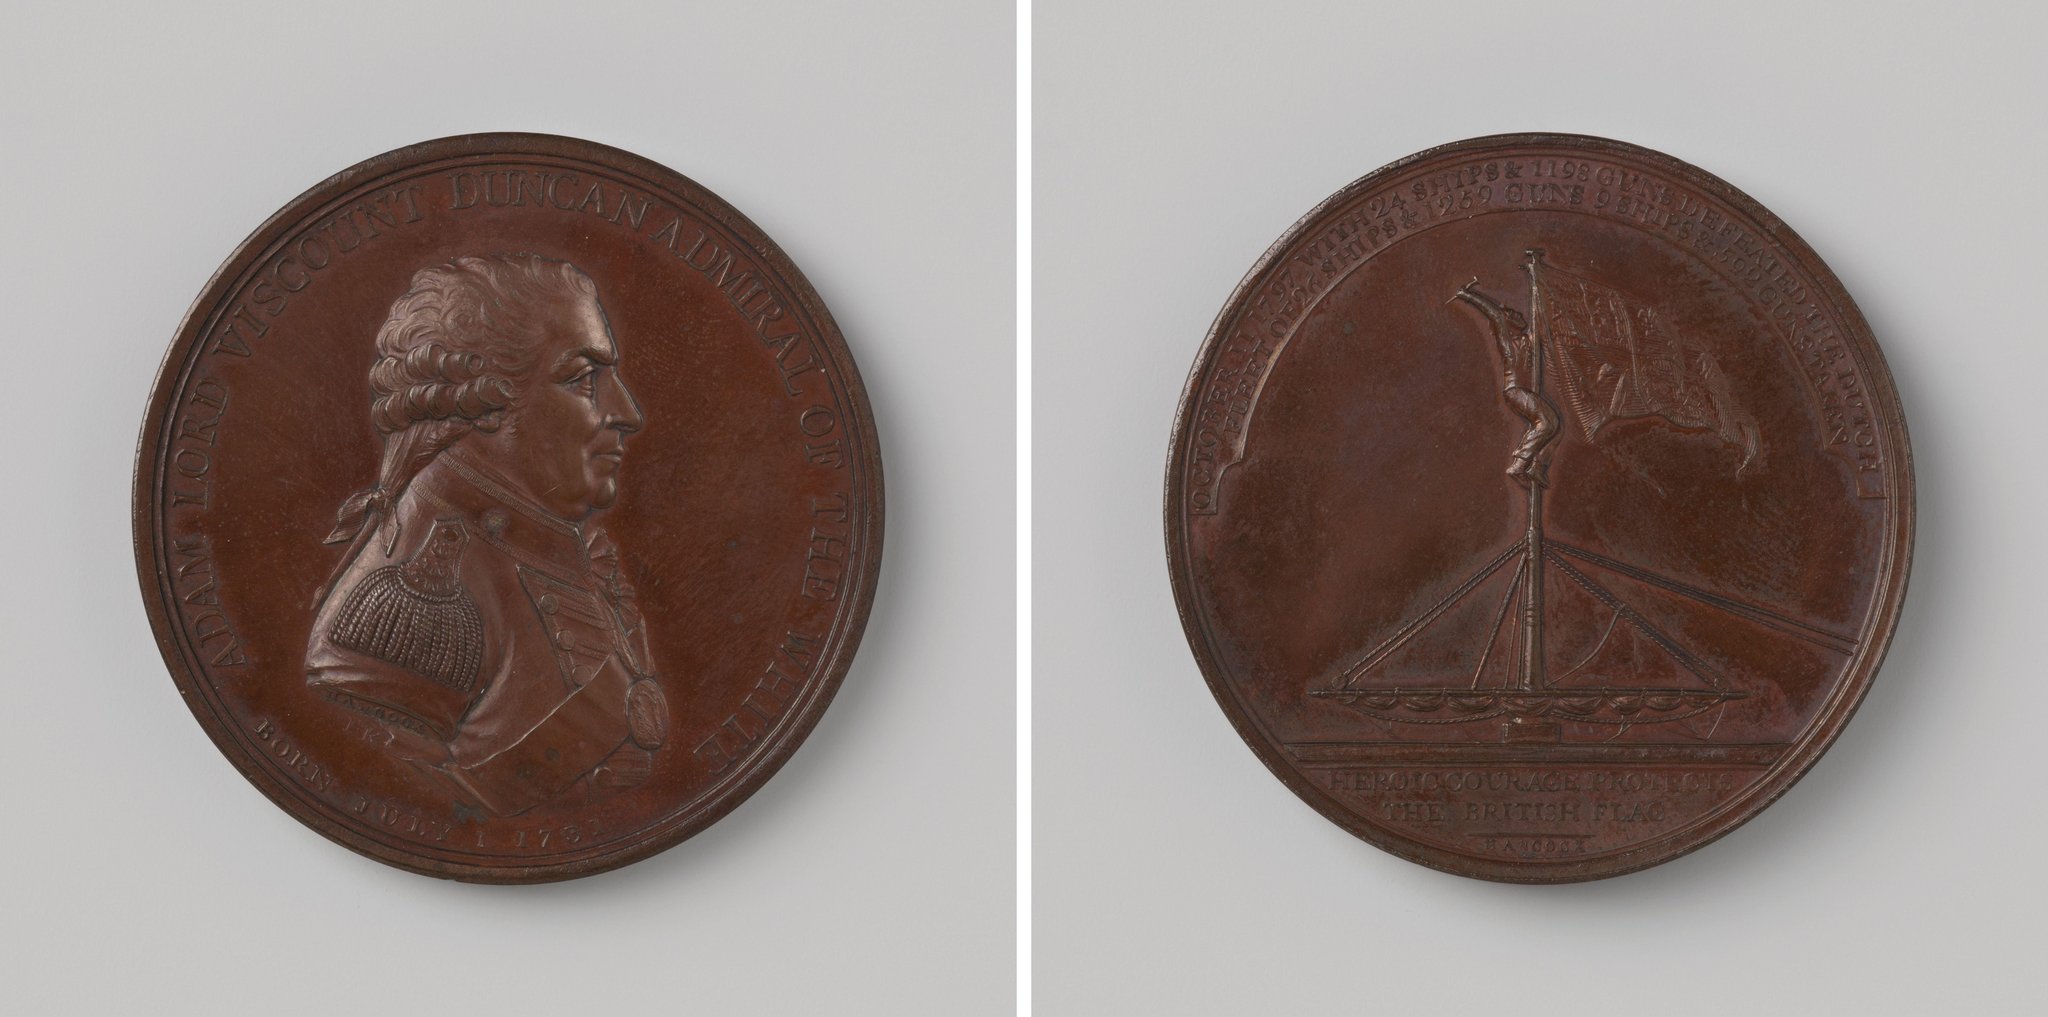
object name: history medal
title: Slag bij Kamperduin, ter ere van Adam Duncan, admiraal van de Britse vloot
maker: john gregory hancock (sr.)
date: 1797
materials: bronze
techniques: striking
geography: birmingham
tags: adam duncan (burggraaf van duncan), battle of camperdown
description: Bronzen penning. Voorzijde: borststuk man binnen omschrift. Keerzijde: zeeman bevestigt vlag in top van mast binnen omschrift; afsnede: opschrift